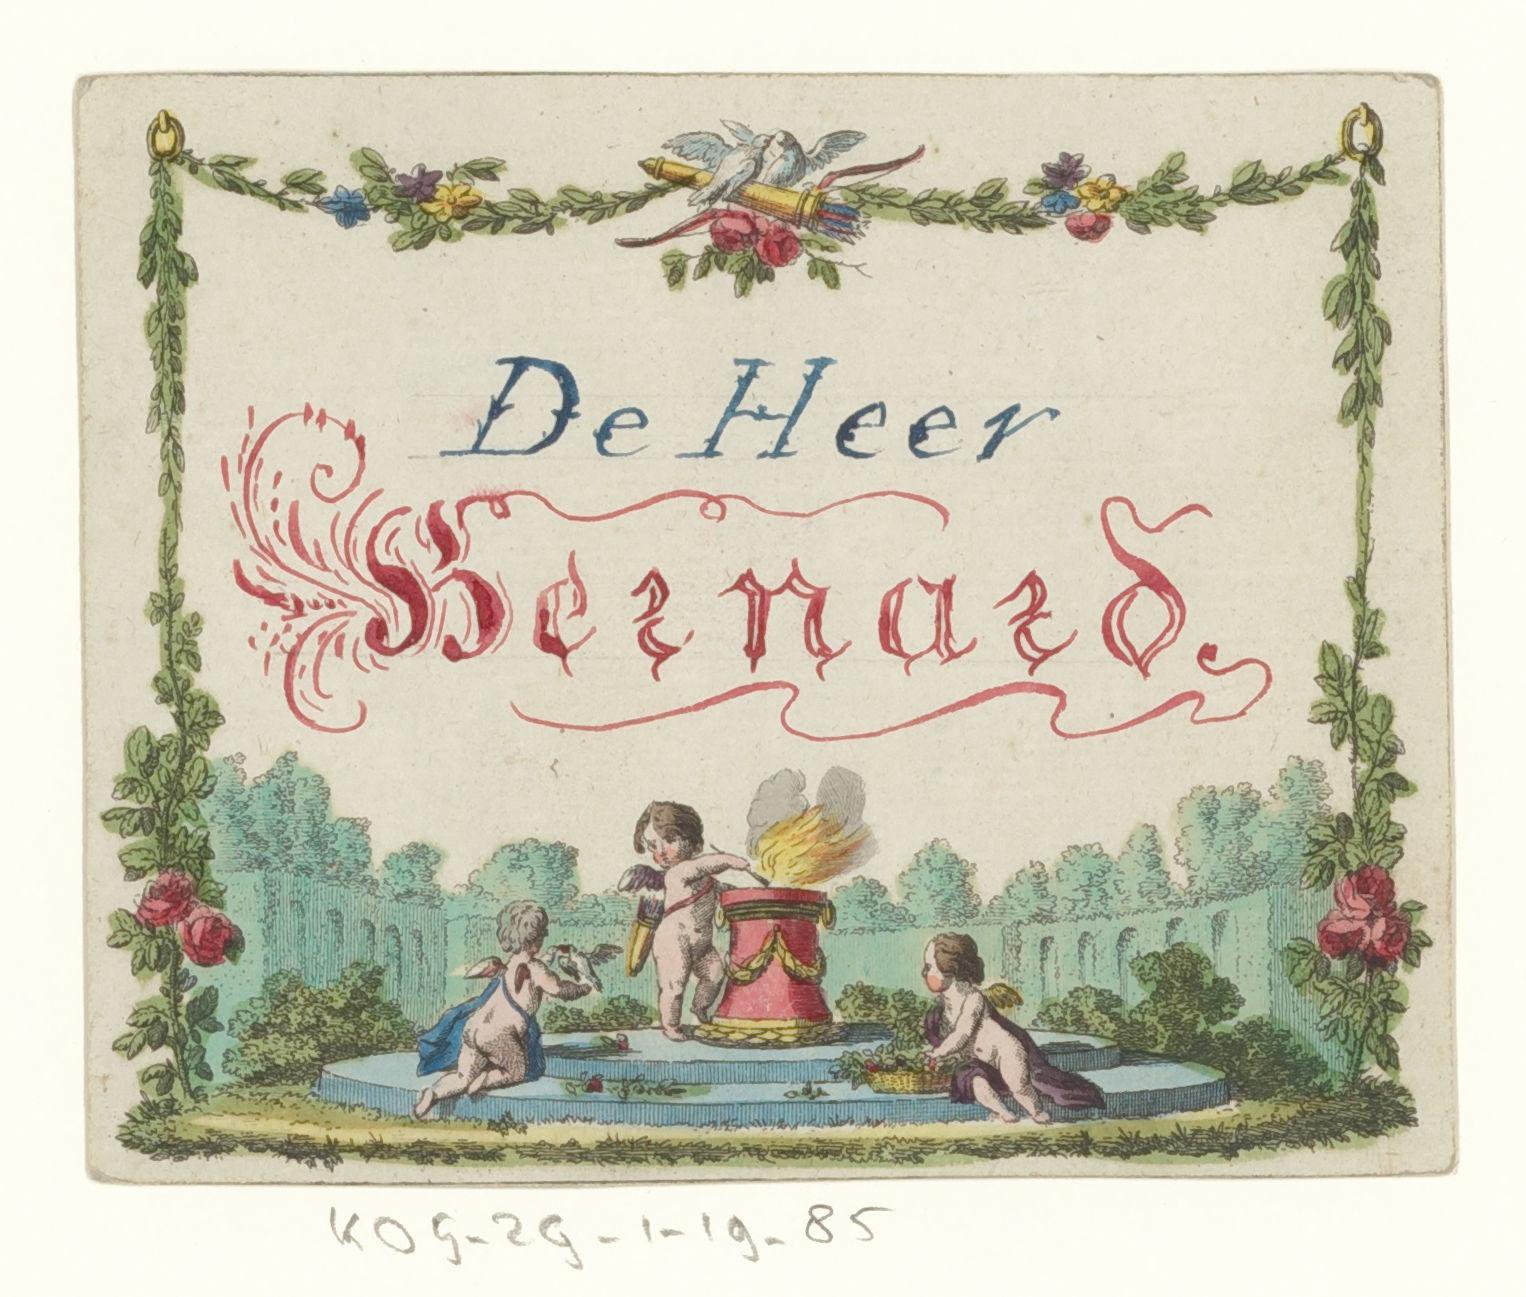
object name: print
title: Bruiloftskaart voor 'De Heer Bernard'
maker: Anonymous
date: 1780-1800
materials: paper, watercolor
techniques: etching, hand coloring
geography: netherlands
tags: wedding feast, wedding meal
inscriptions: collector's mark, collector's mark: Lugt 1641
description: Naamkaartje voor de heer Bernard, te gebruiken bij de tafelindeling bij een bruiloftsmaal. Onderdeel van een groep van bruilofts- en invitatiekaartjes van de families Bernard en Metayer. Onderwerpsrubrieken binnen de Atlas Zeden en Gewoonten: Des Menschen Begin, Midden en Einde. Bruiloft en huwelijk.